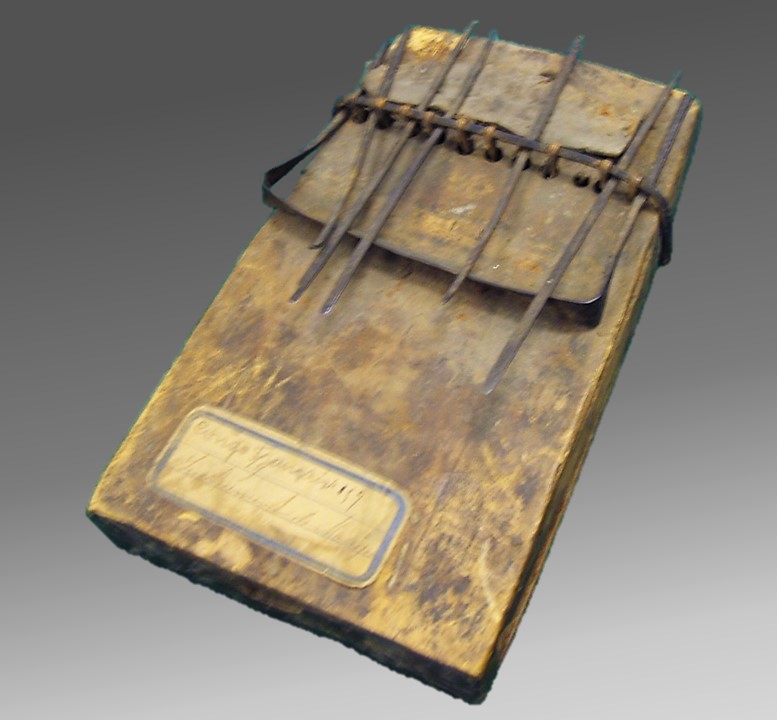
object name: zanze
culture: gabonese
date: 1867-1900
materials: metal, wood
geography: gabon